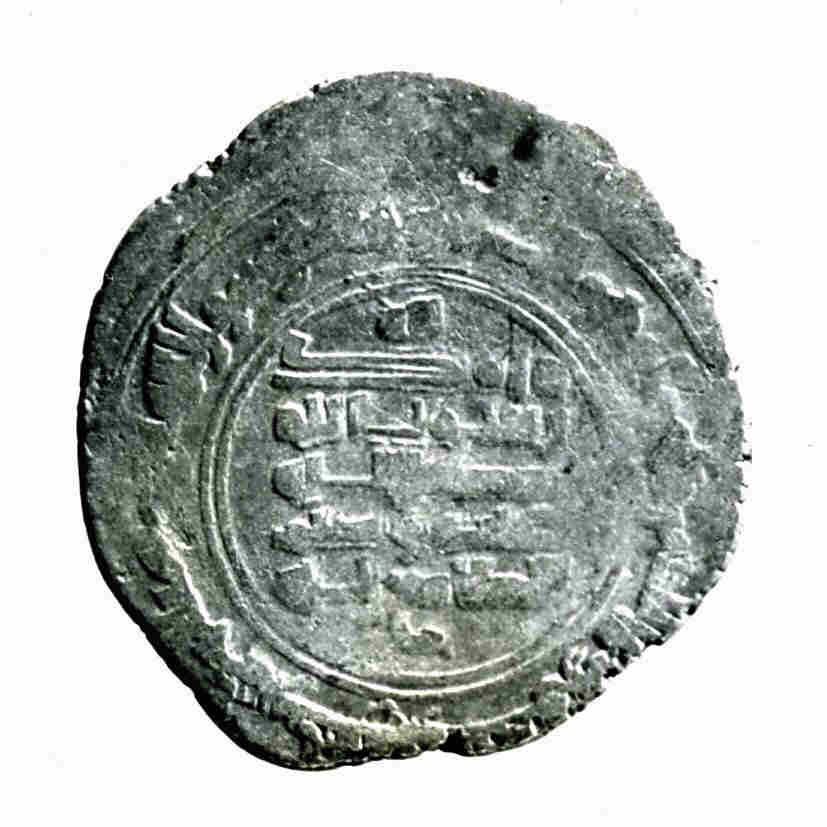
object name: coin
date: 977-982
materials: silver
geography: iran